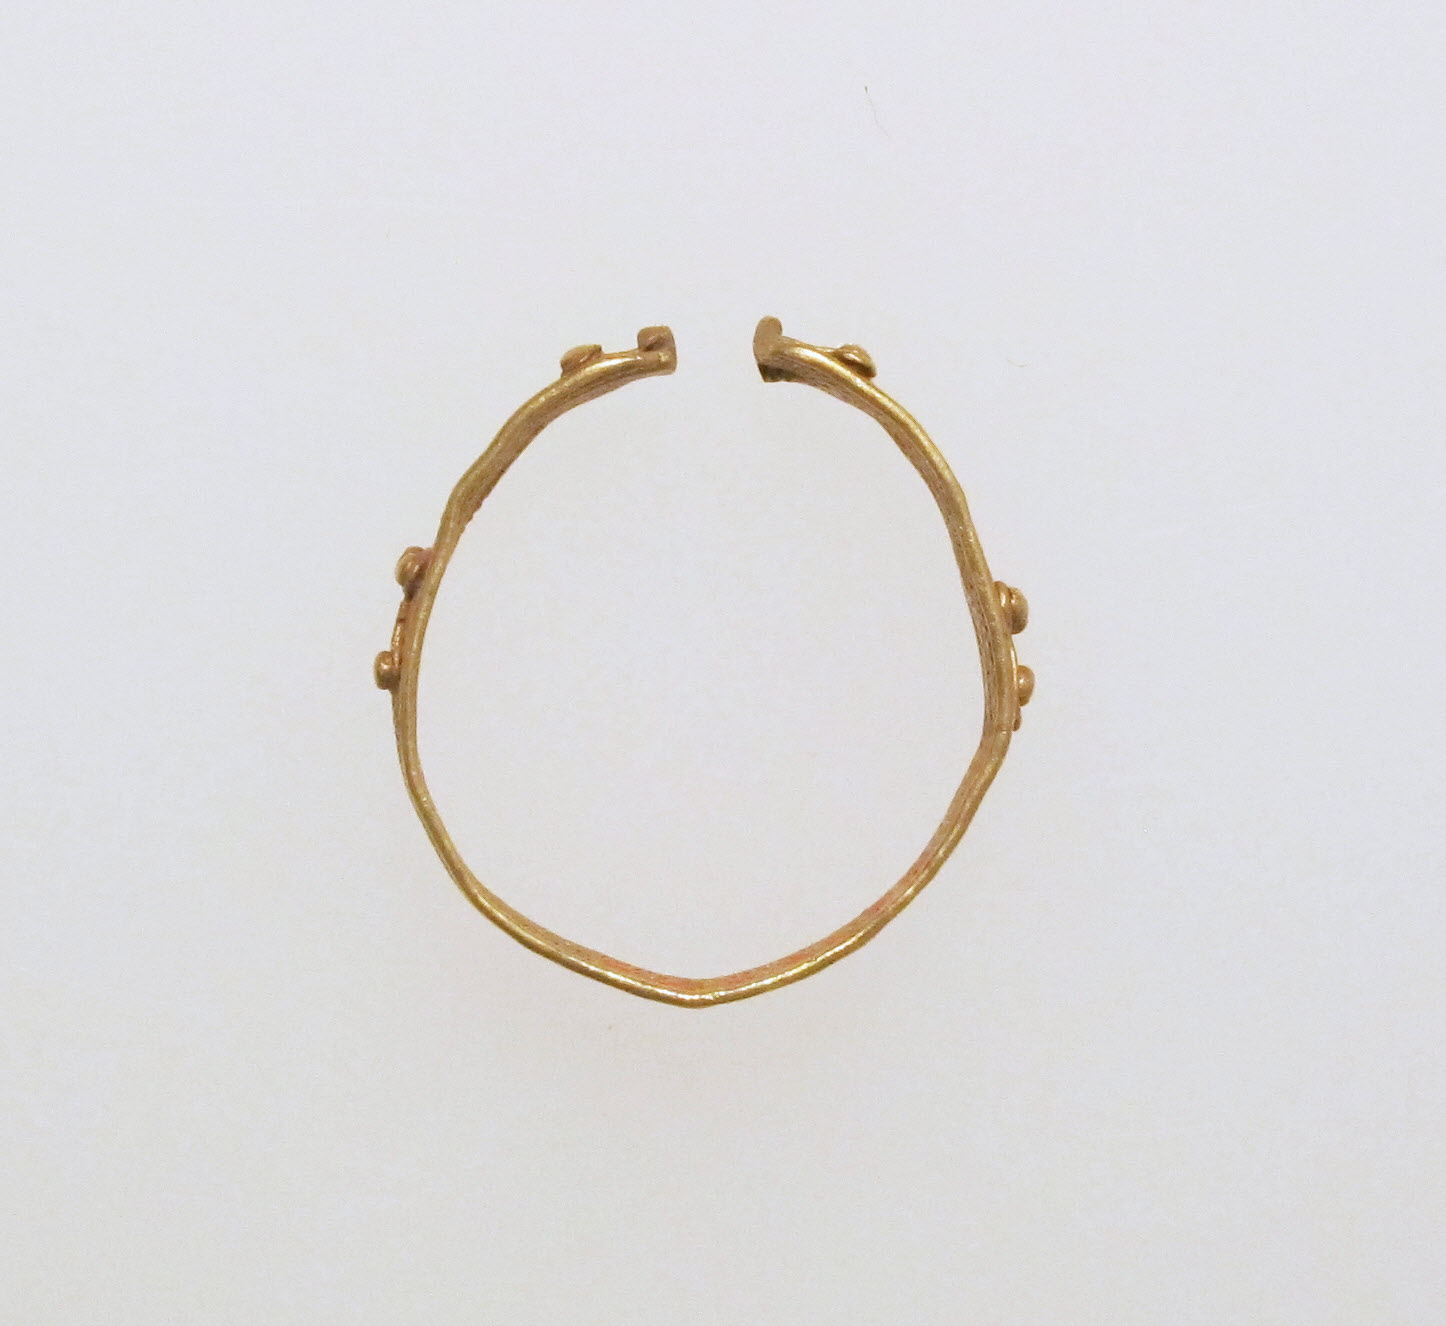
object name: ring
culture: etruscan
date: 900-100 BCE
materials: gold